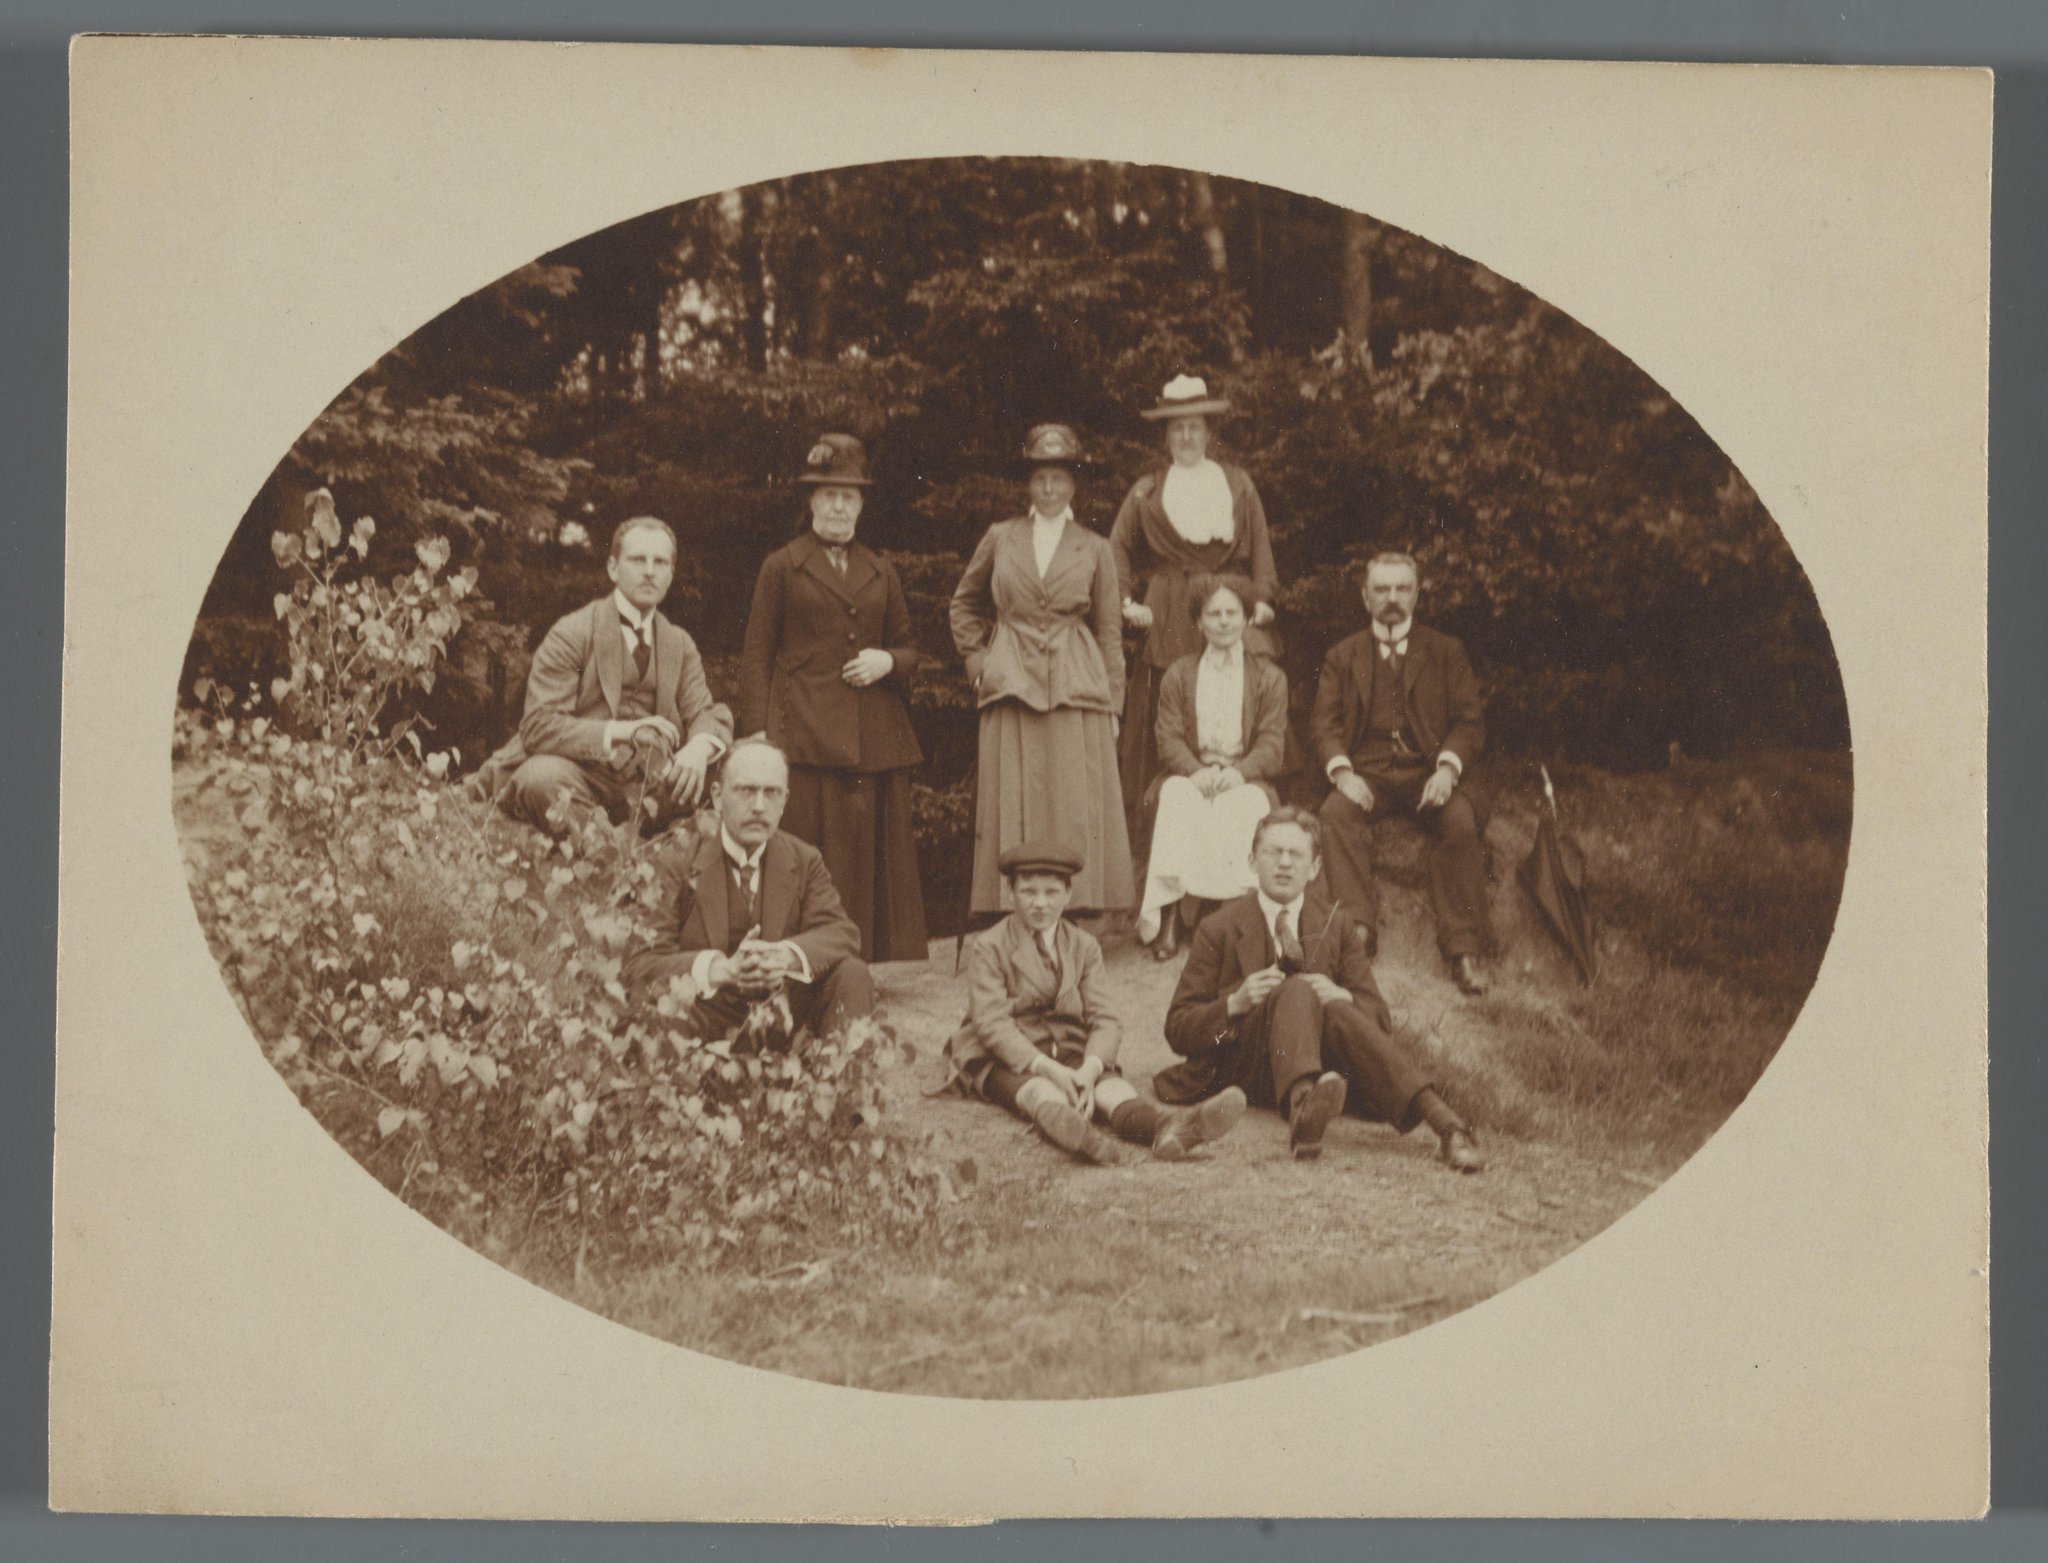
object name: photograph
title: Portret van een onbekende familie in het bos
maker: Anonymous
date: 1890-1930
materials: photographic support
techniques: gelatin silver print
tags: forest, wood, anonymous historical persons portrayed in a group, in a group-portrait